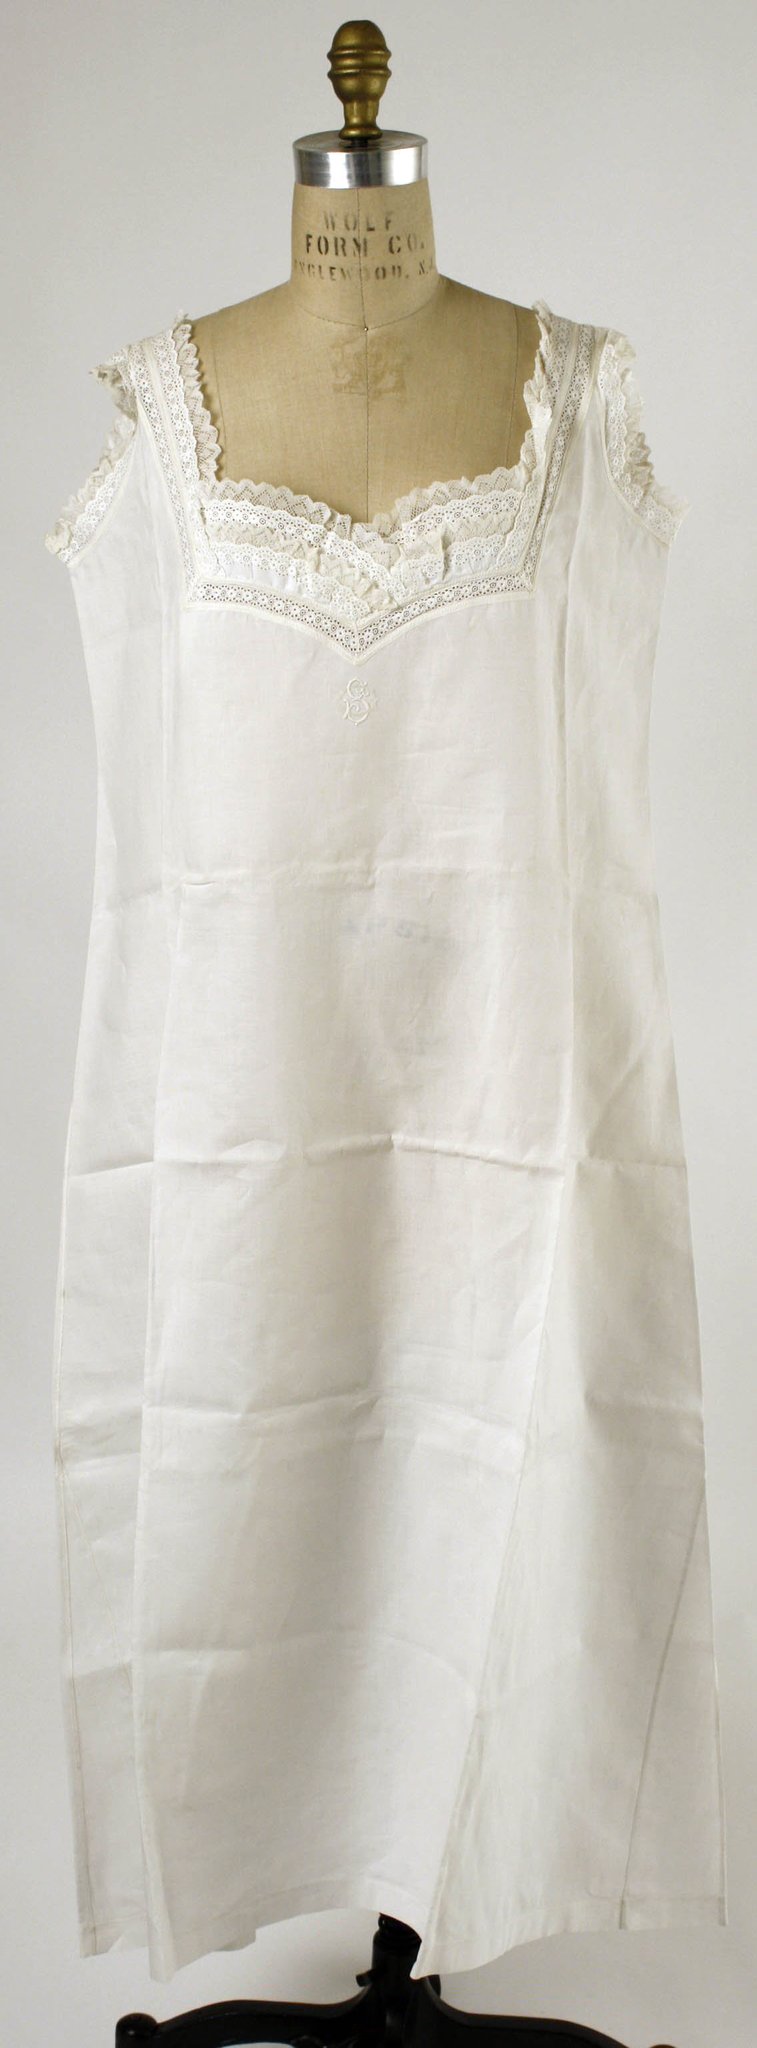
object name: chemise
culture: american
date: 1880-1889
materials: linen